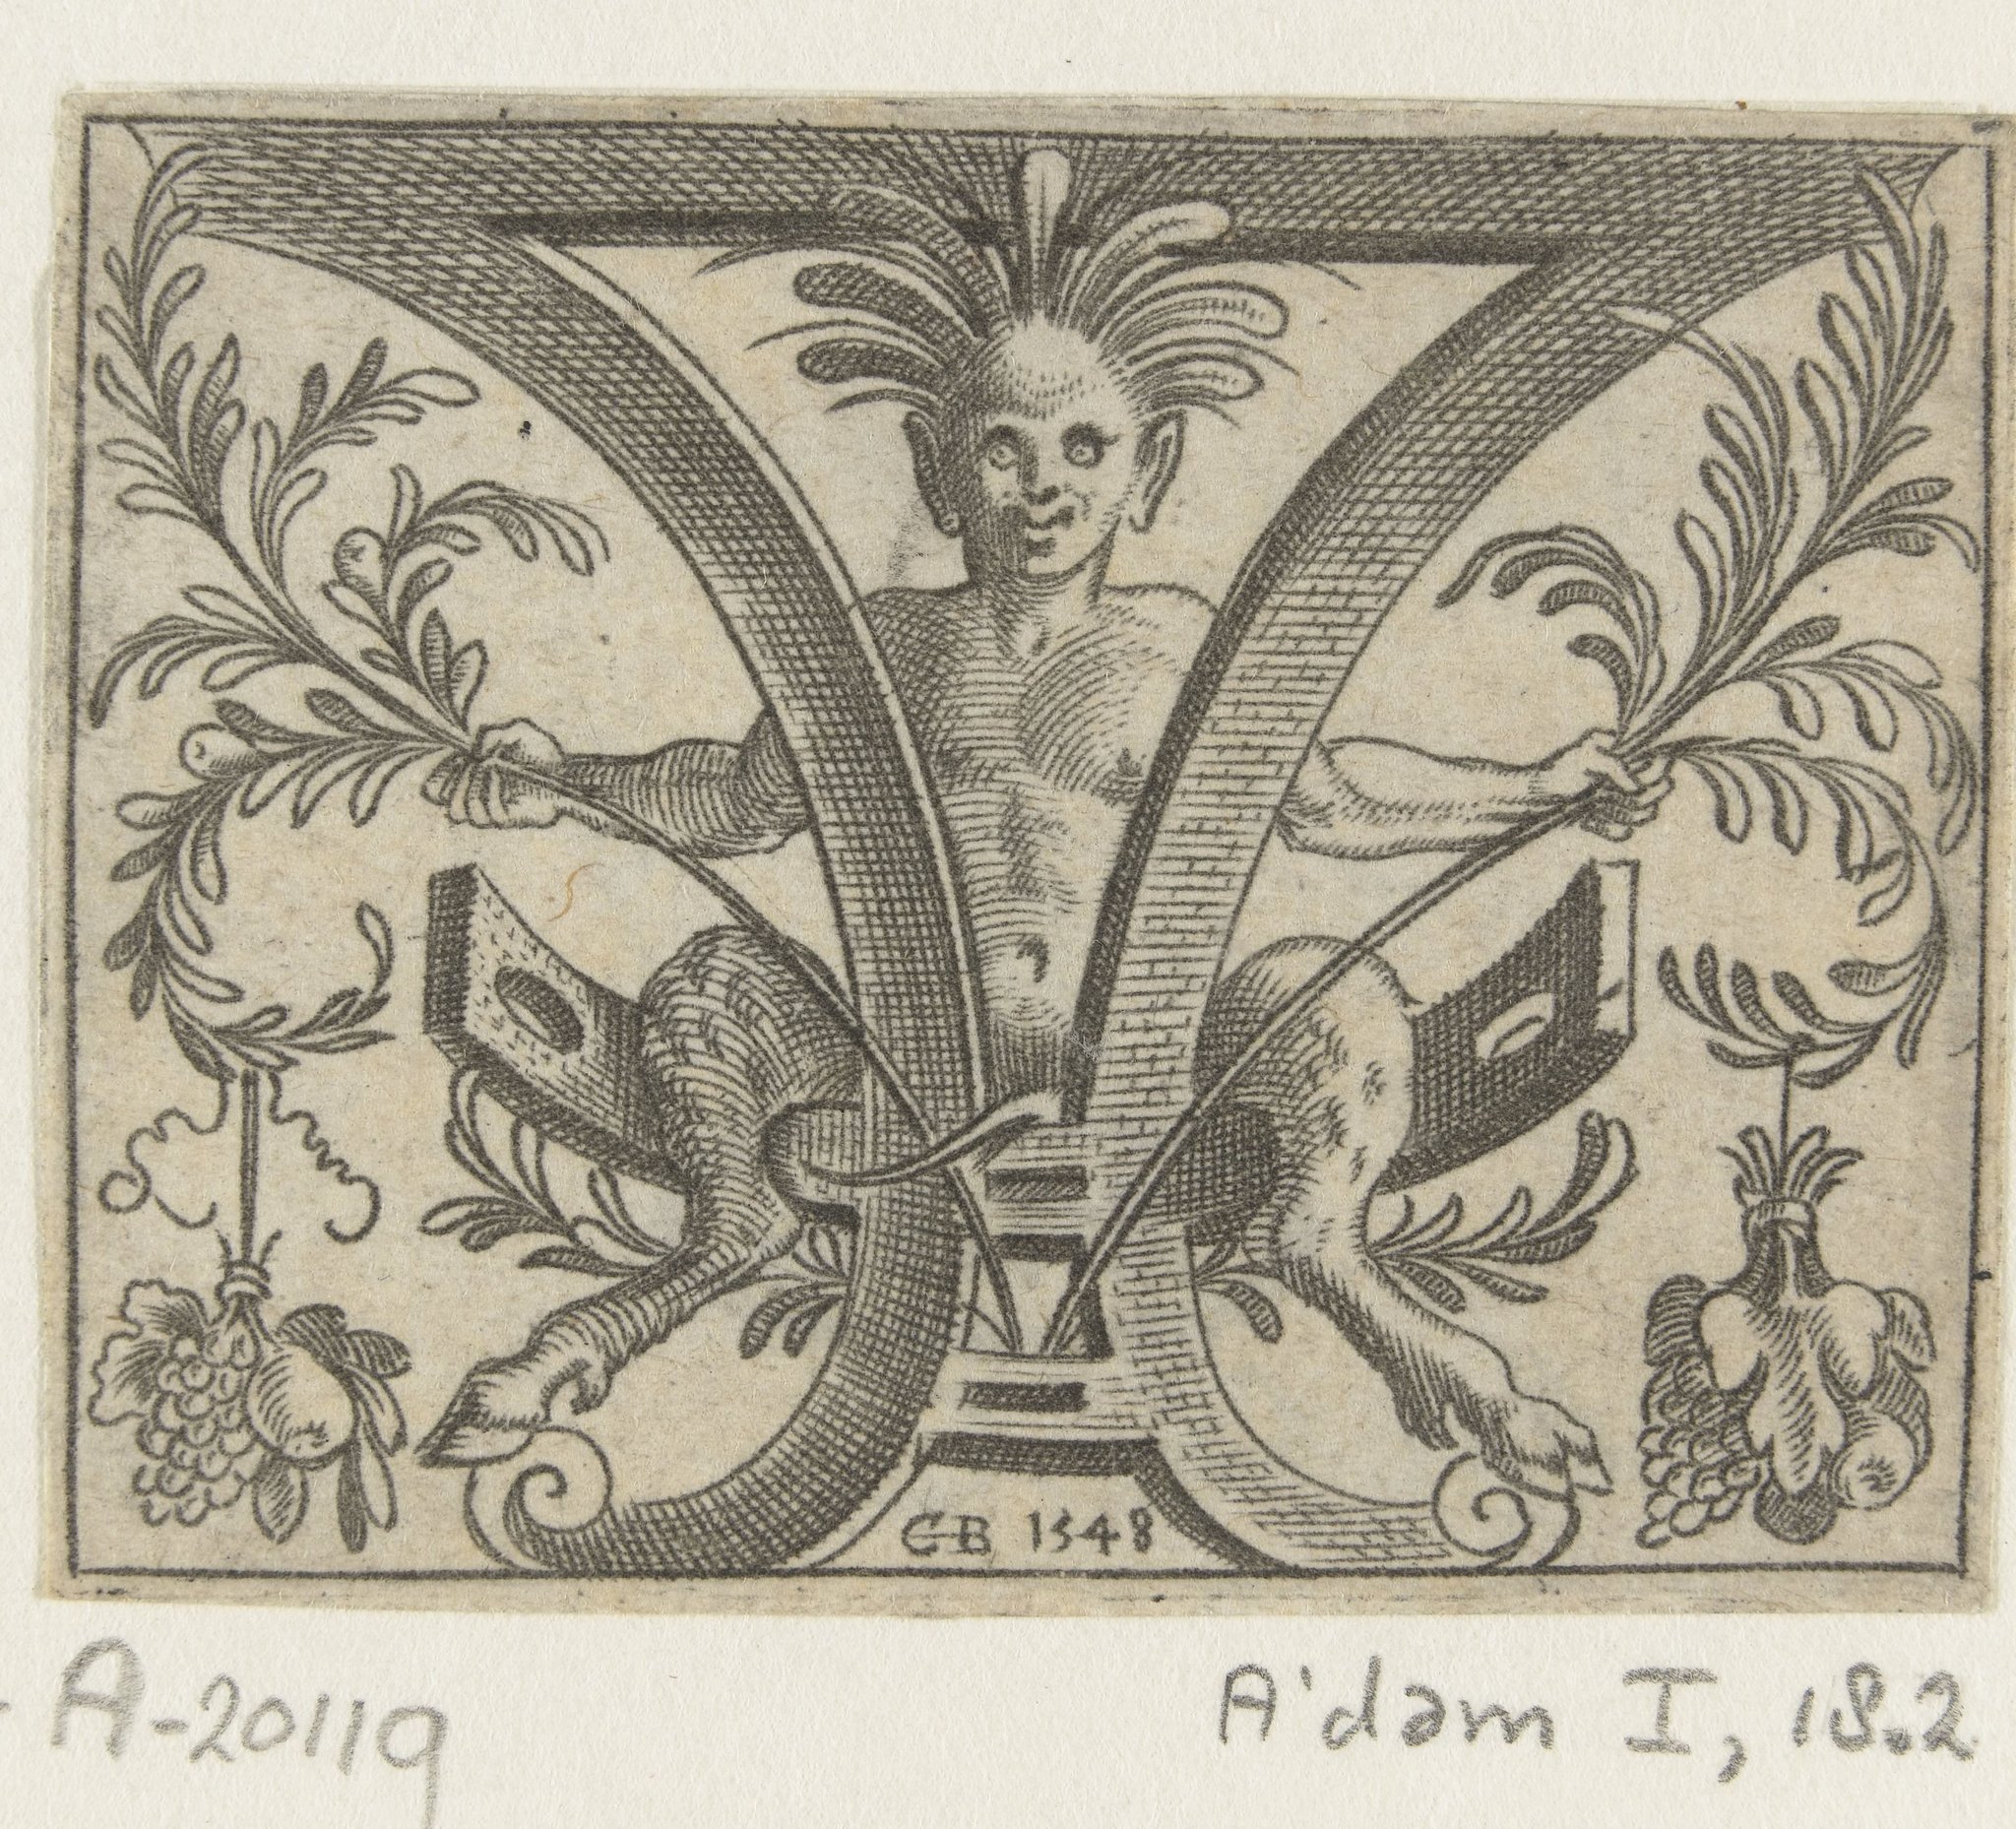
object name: ornament print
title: Sater, zittend in een rolwerk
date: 1548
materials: paper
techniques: engraving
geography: netherlands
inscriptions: date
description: In elke hand houdt de sater een lauriertak waar een trosje fruit aan hangt. Een van 4 bladen uit een serie van 8.